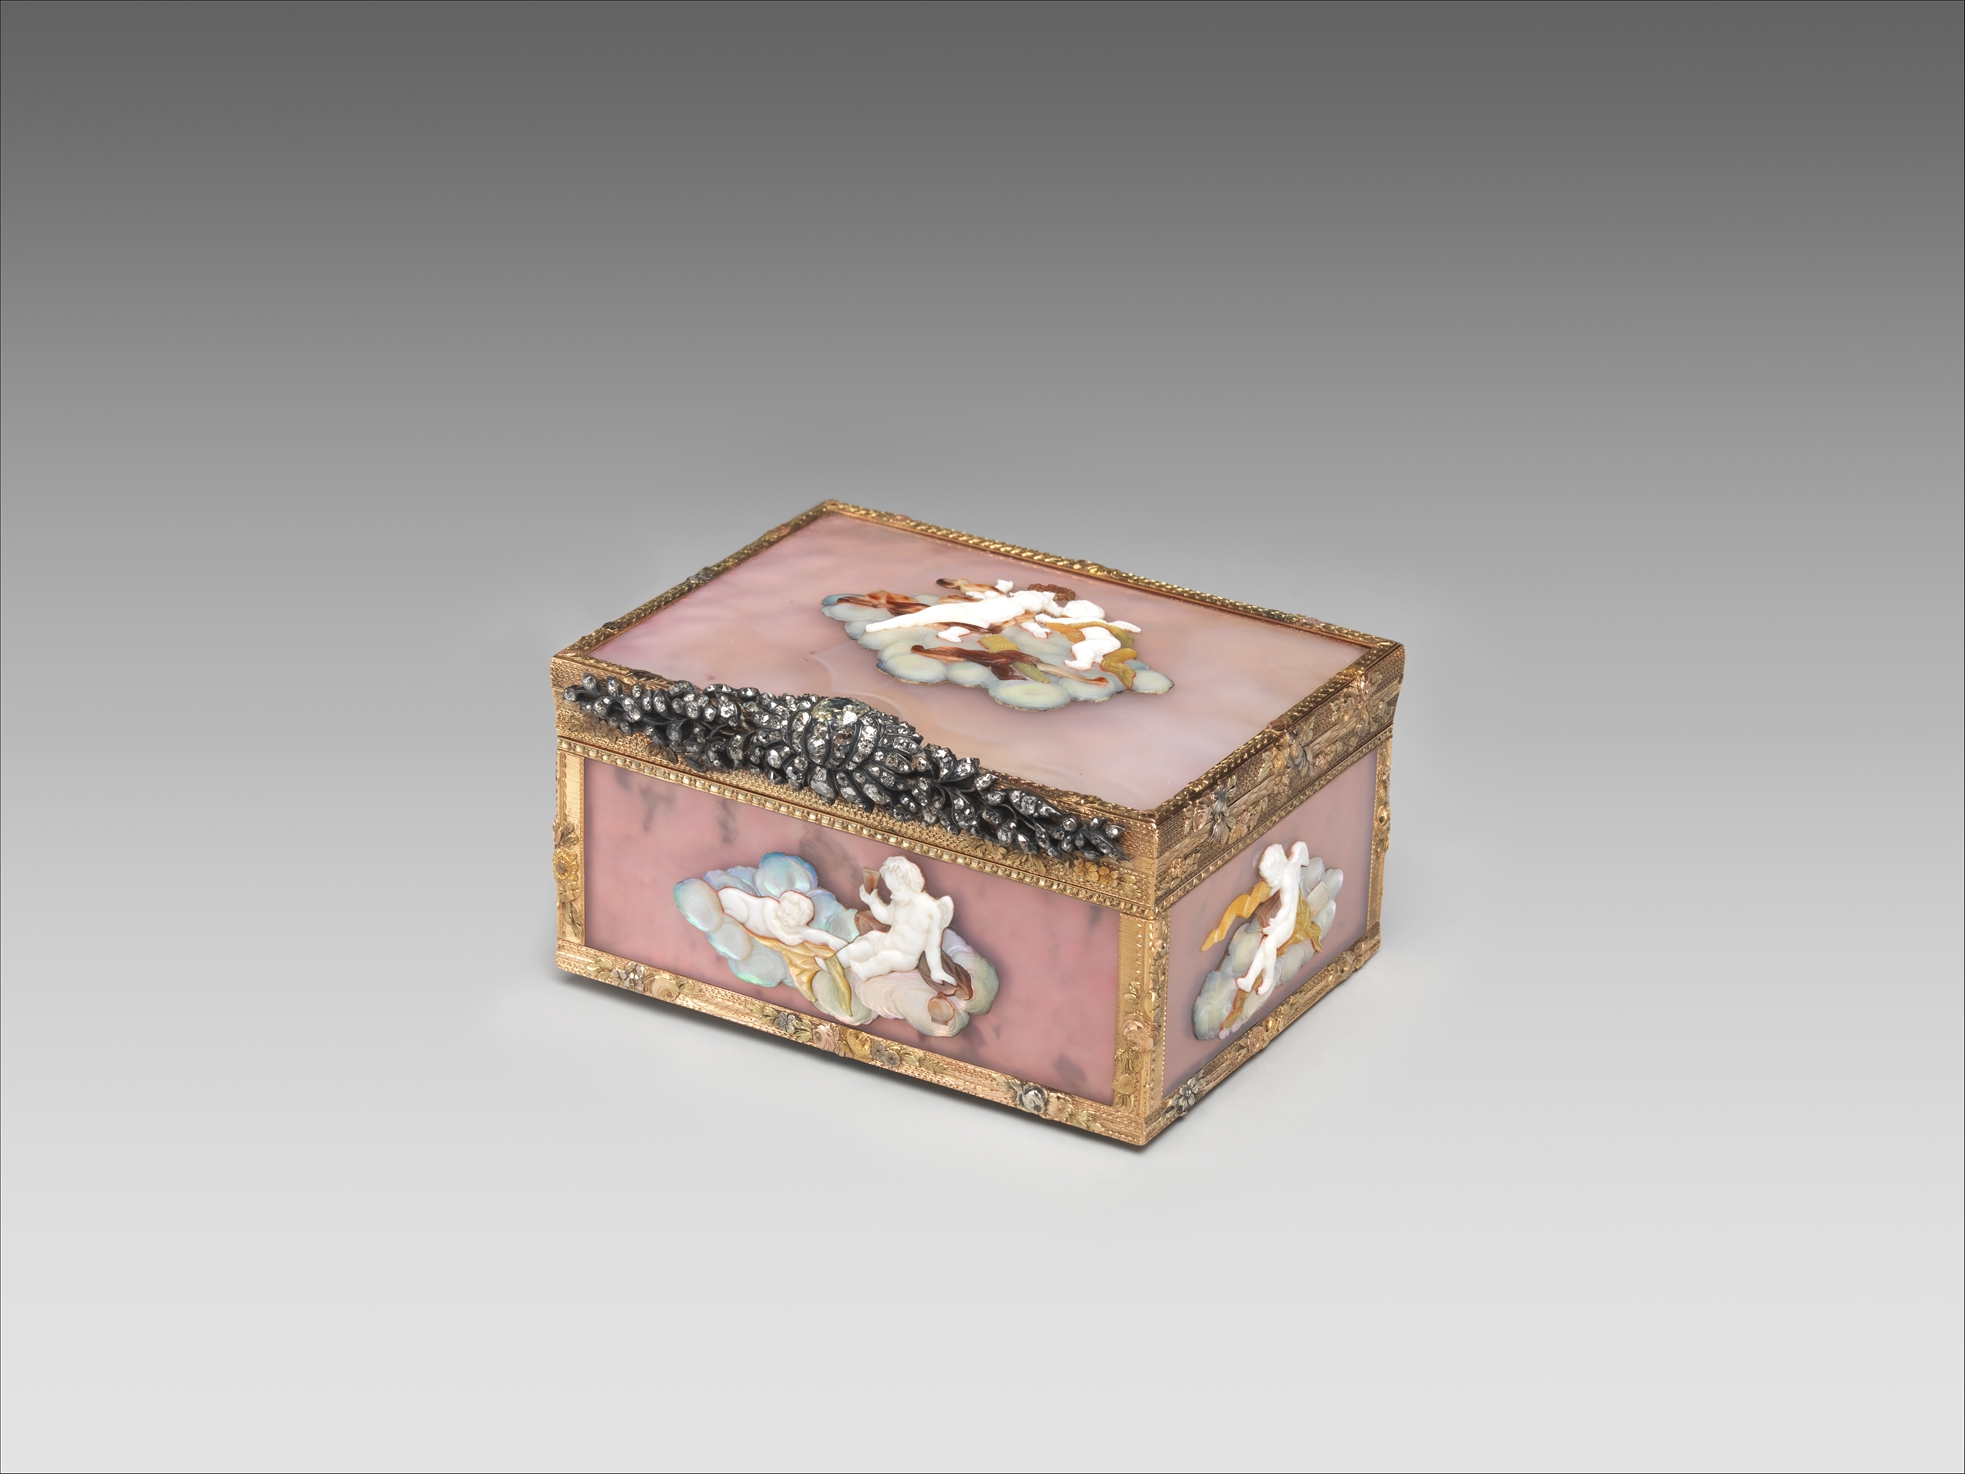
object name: snuffbox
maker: d. b., stettin, germany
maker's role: maker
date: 1776-1800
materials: stone, diamond, foil, gold, ivory, mother of pearl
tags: cupid